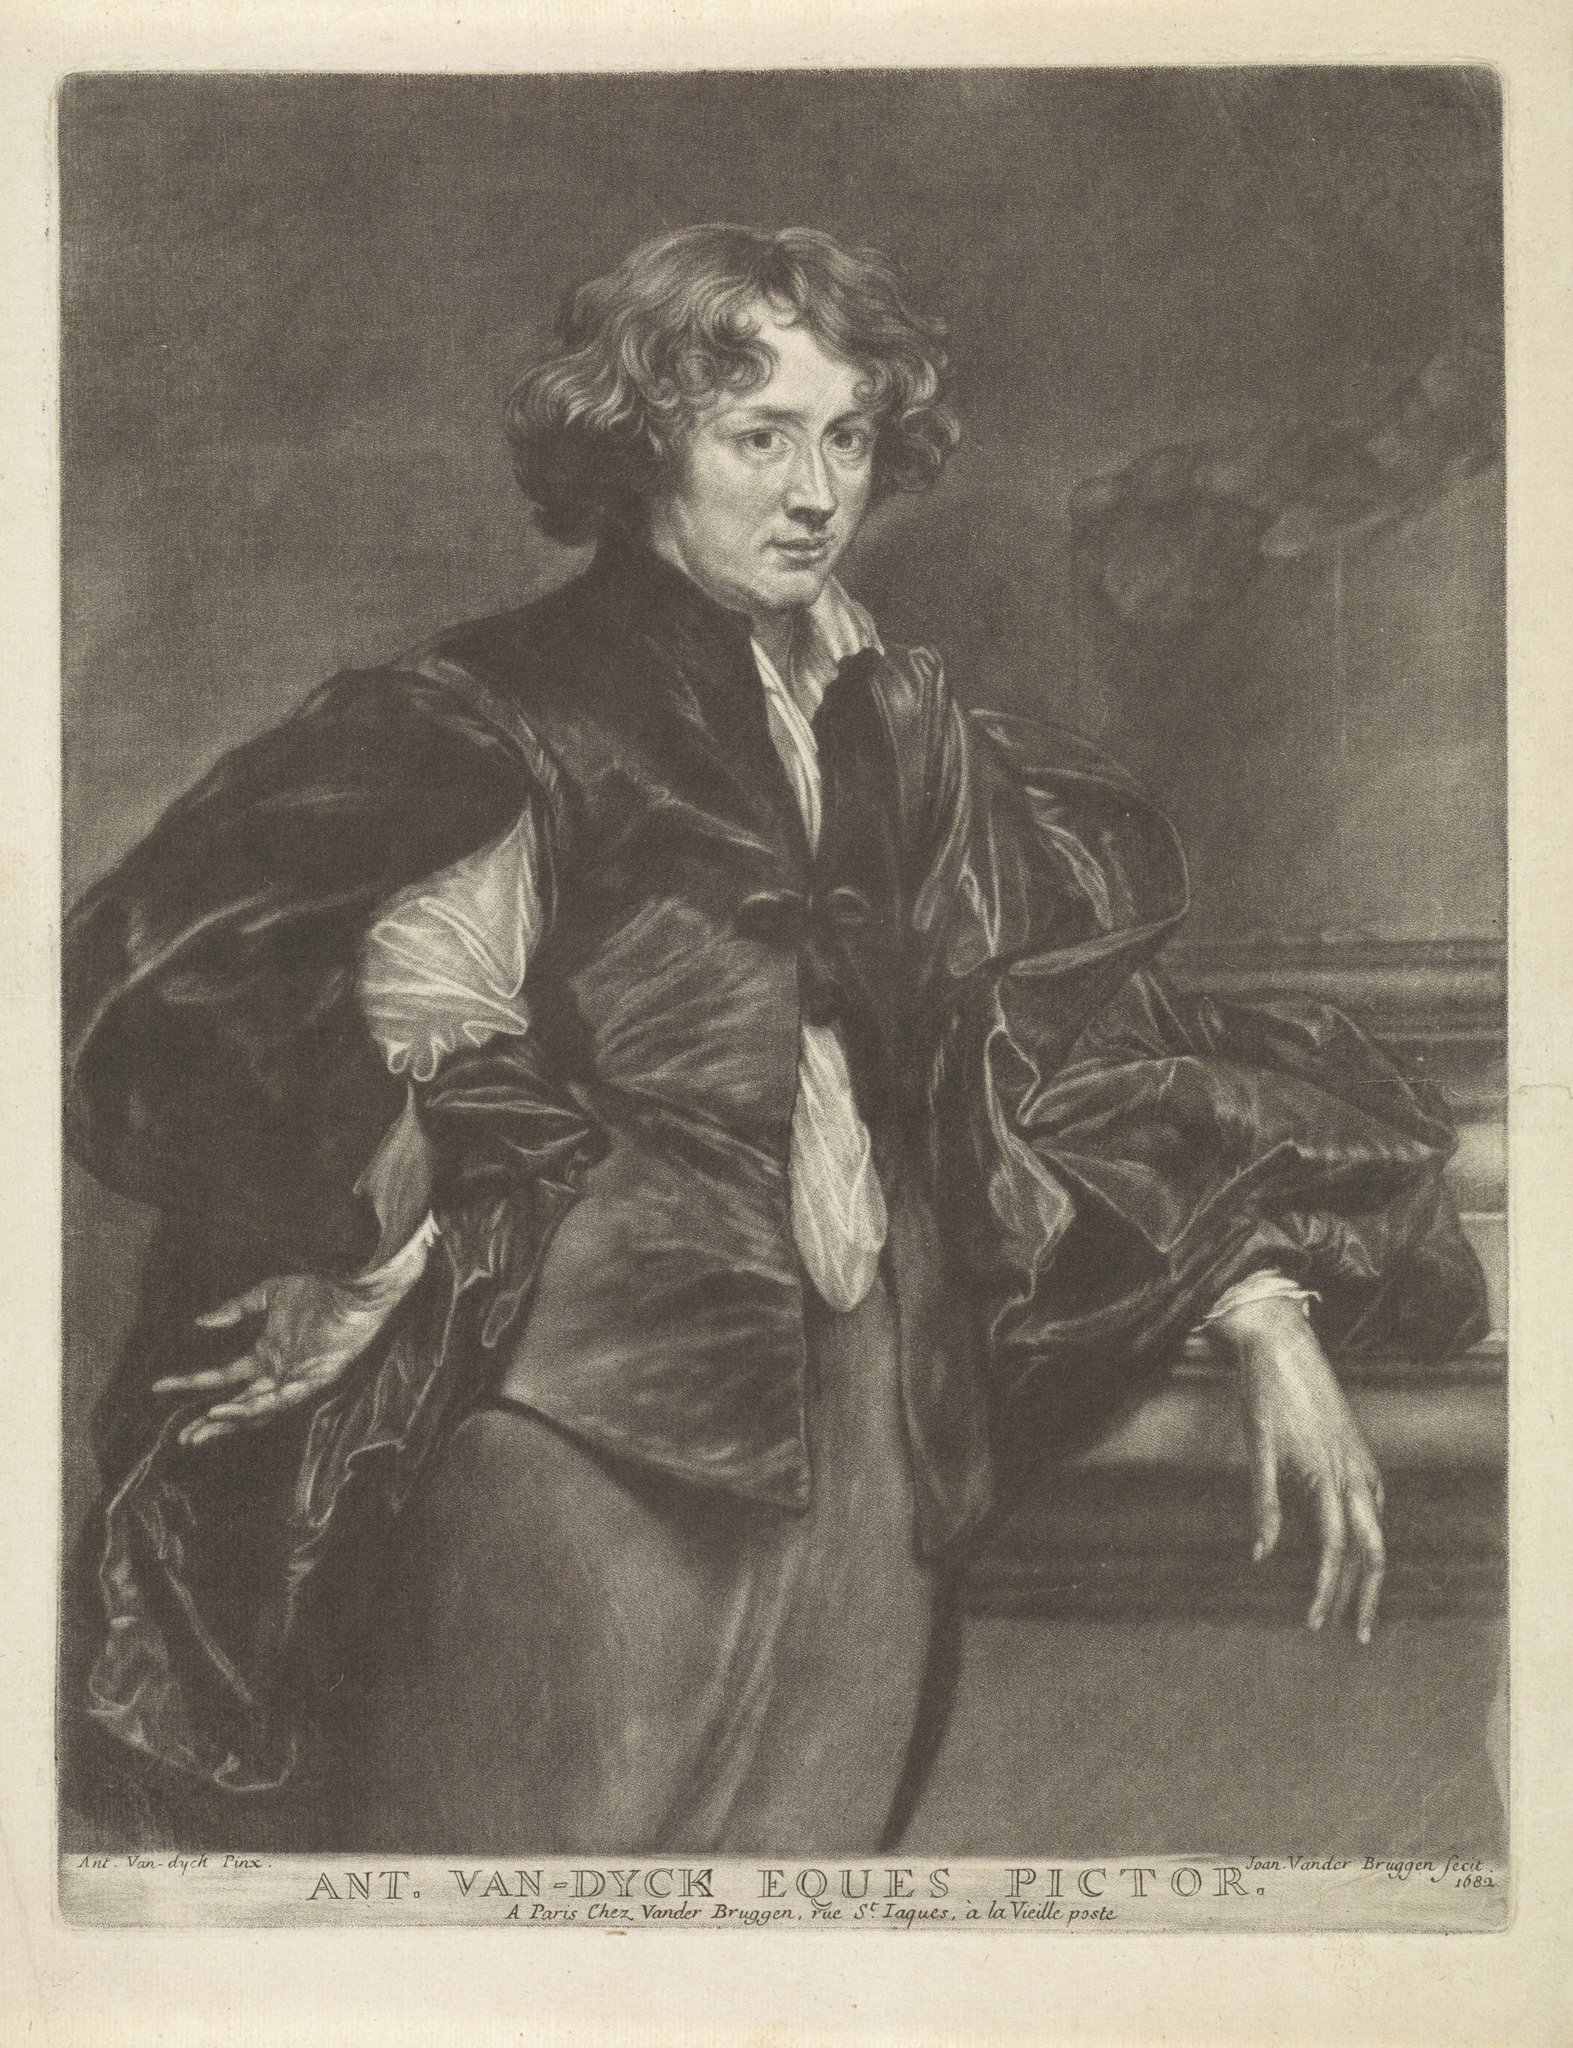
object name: print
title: Zelfportret van Anthony van Dyck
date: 1682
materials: paper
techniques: engraving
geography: paris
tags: painter, print maker, draughtsman, anthony van dyck, portrait, self-portrait of painter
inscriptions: collector's mark: Lugt 2228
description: Zelfportret van de Vlaamse schilder Anthony van Dyck.